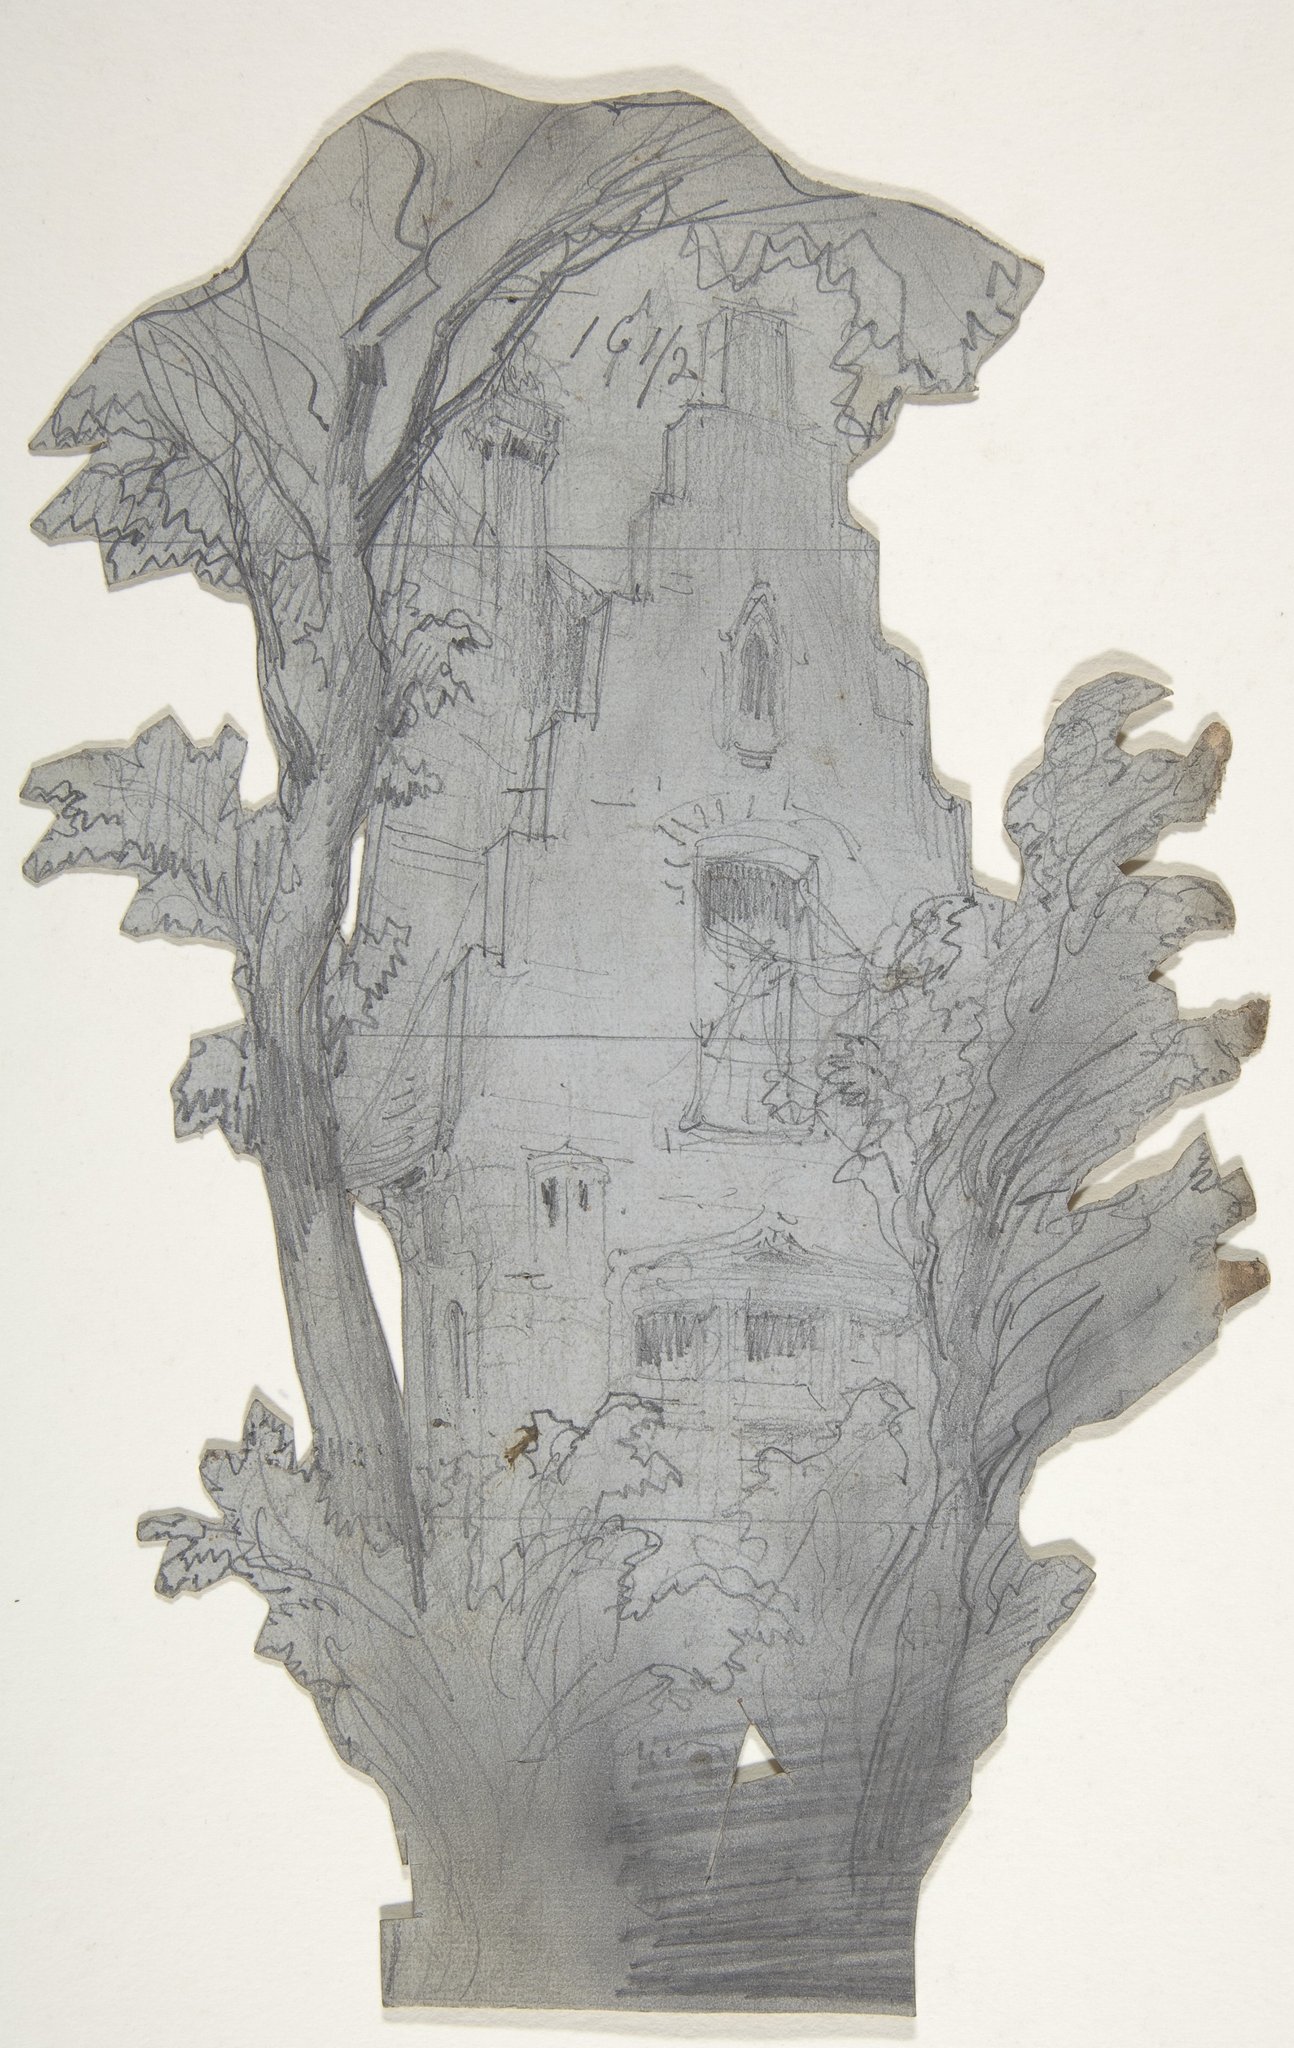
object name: drawing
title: Design for a Stage Set at the Opéra, Paris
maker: eugène cicéri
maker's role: artist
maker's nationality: french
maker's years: 1813-1890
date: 1830-1890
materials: graphite, paper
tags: trees,stage design